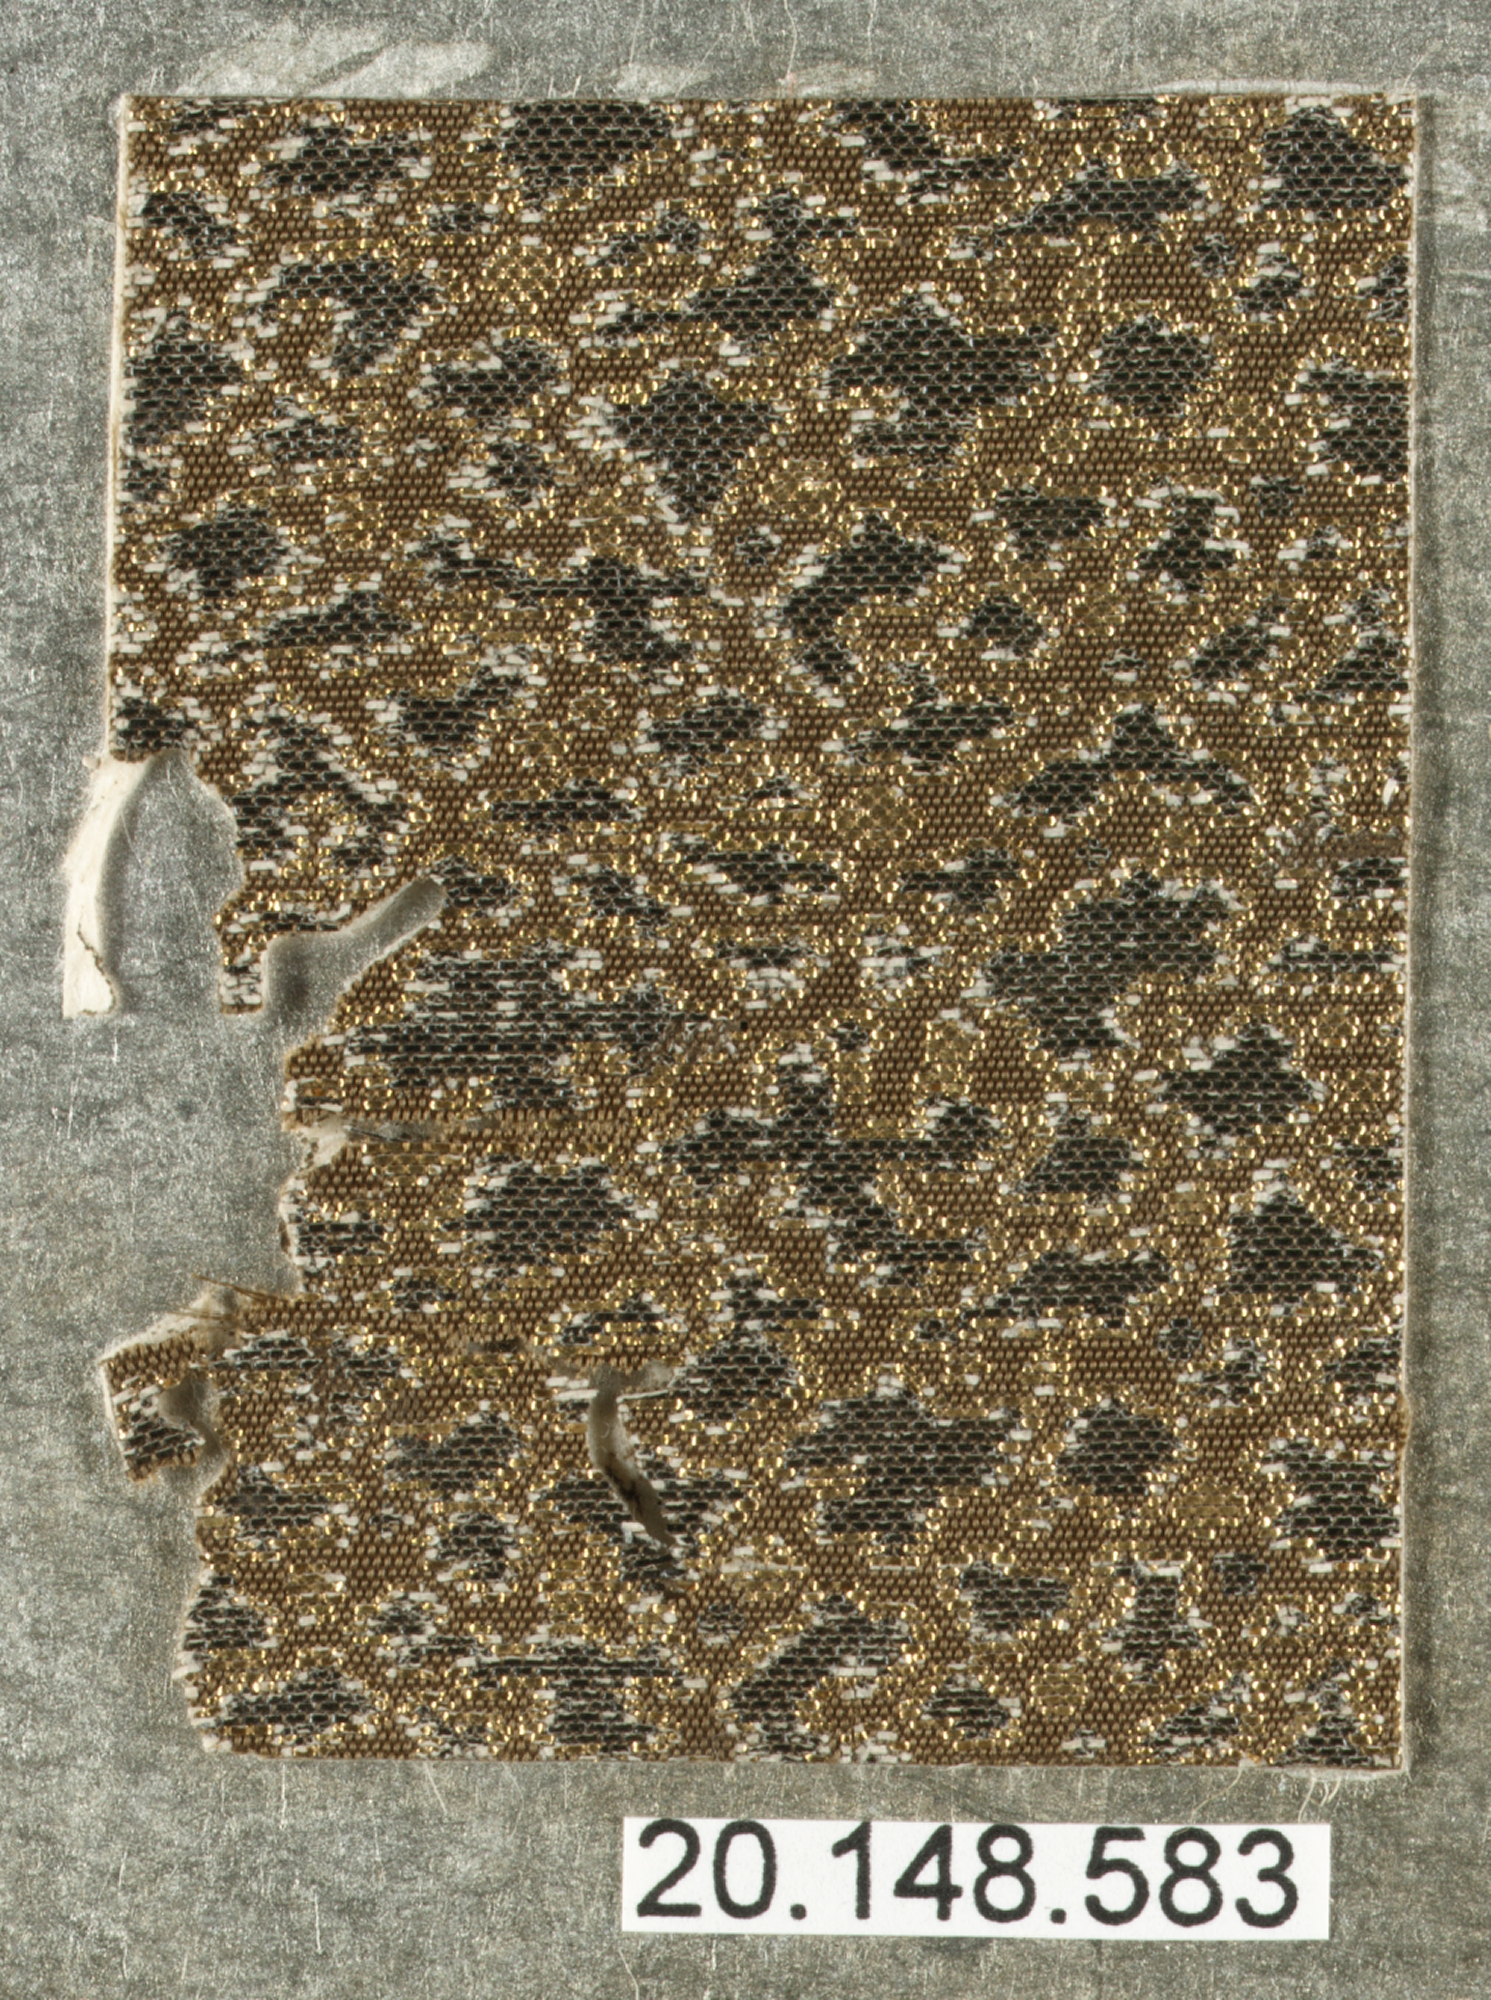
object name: piece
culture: japanese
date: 1701-1800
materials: silk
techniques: compound weave